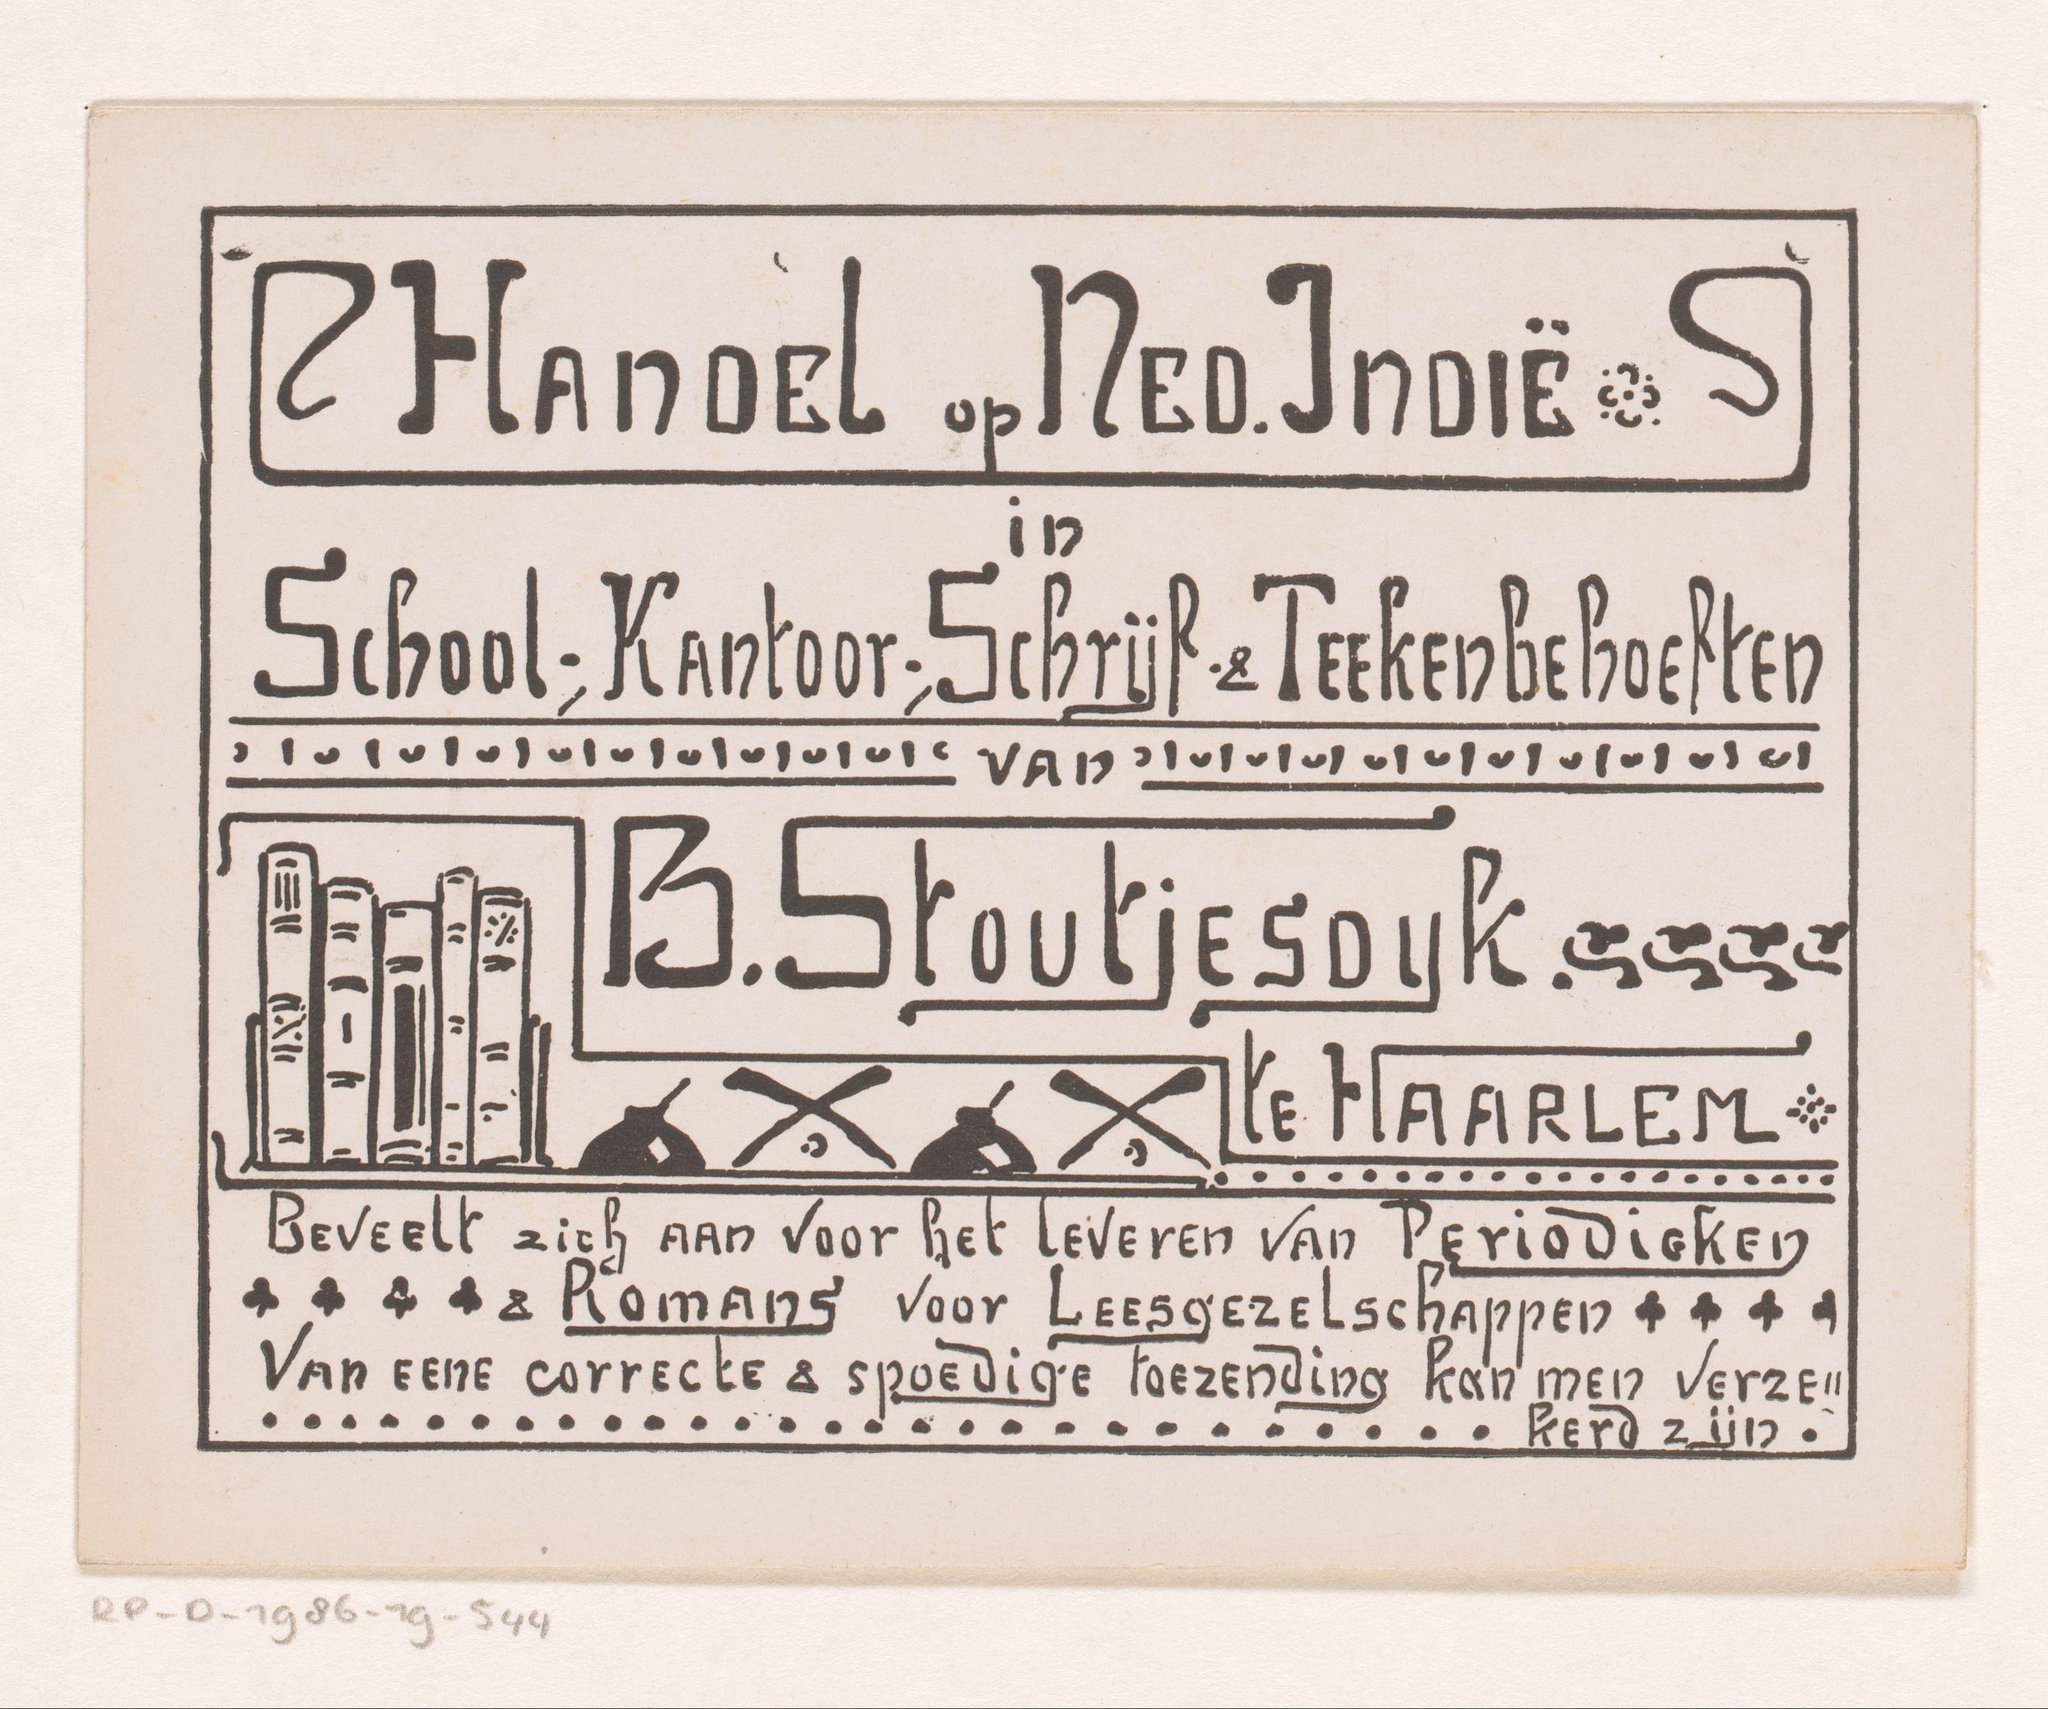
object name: photomechanical print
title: Advertentie van B. Stoutjesdijk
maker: reinier willem petrus de vries (1874-1953)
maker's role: draughtsman, print maker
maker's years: 1874-1953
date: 1895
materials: paper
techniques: printing block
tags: ink-well, pen, book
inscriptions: collector's mark: ‘R:MVS.’